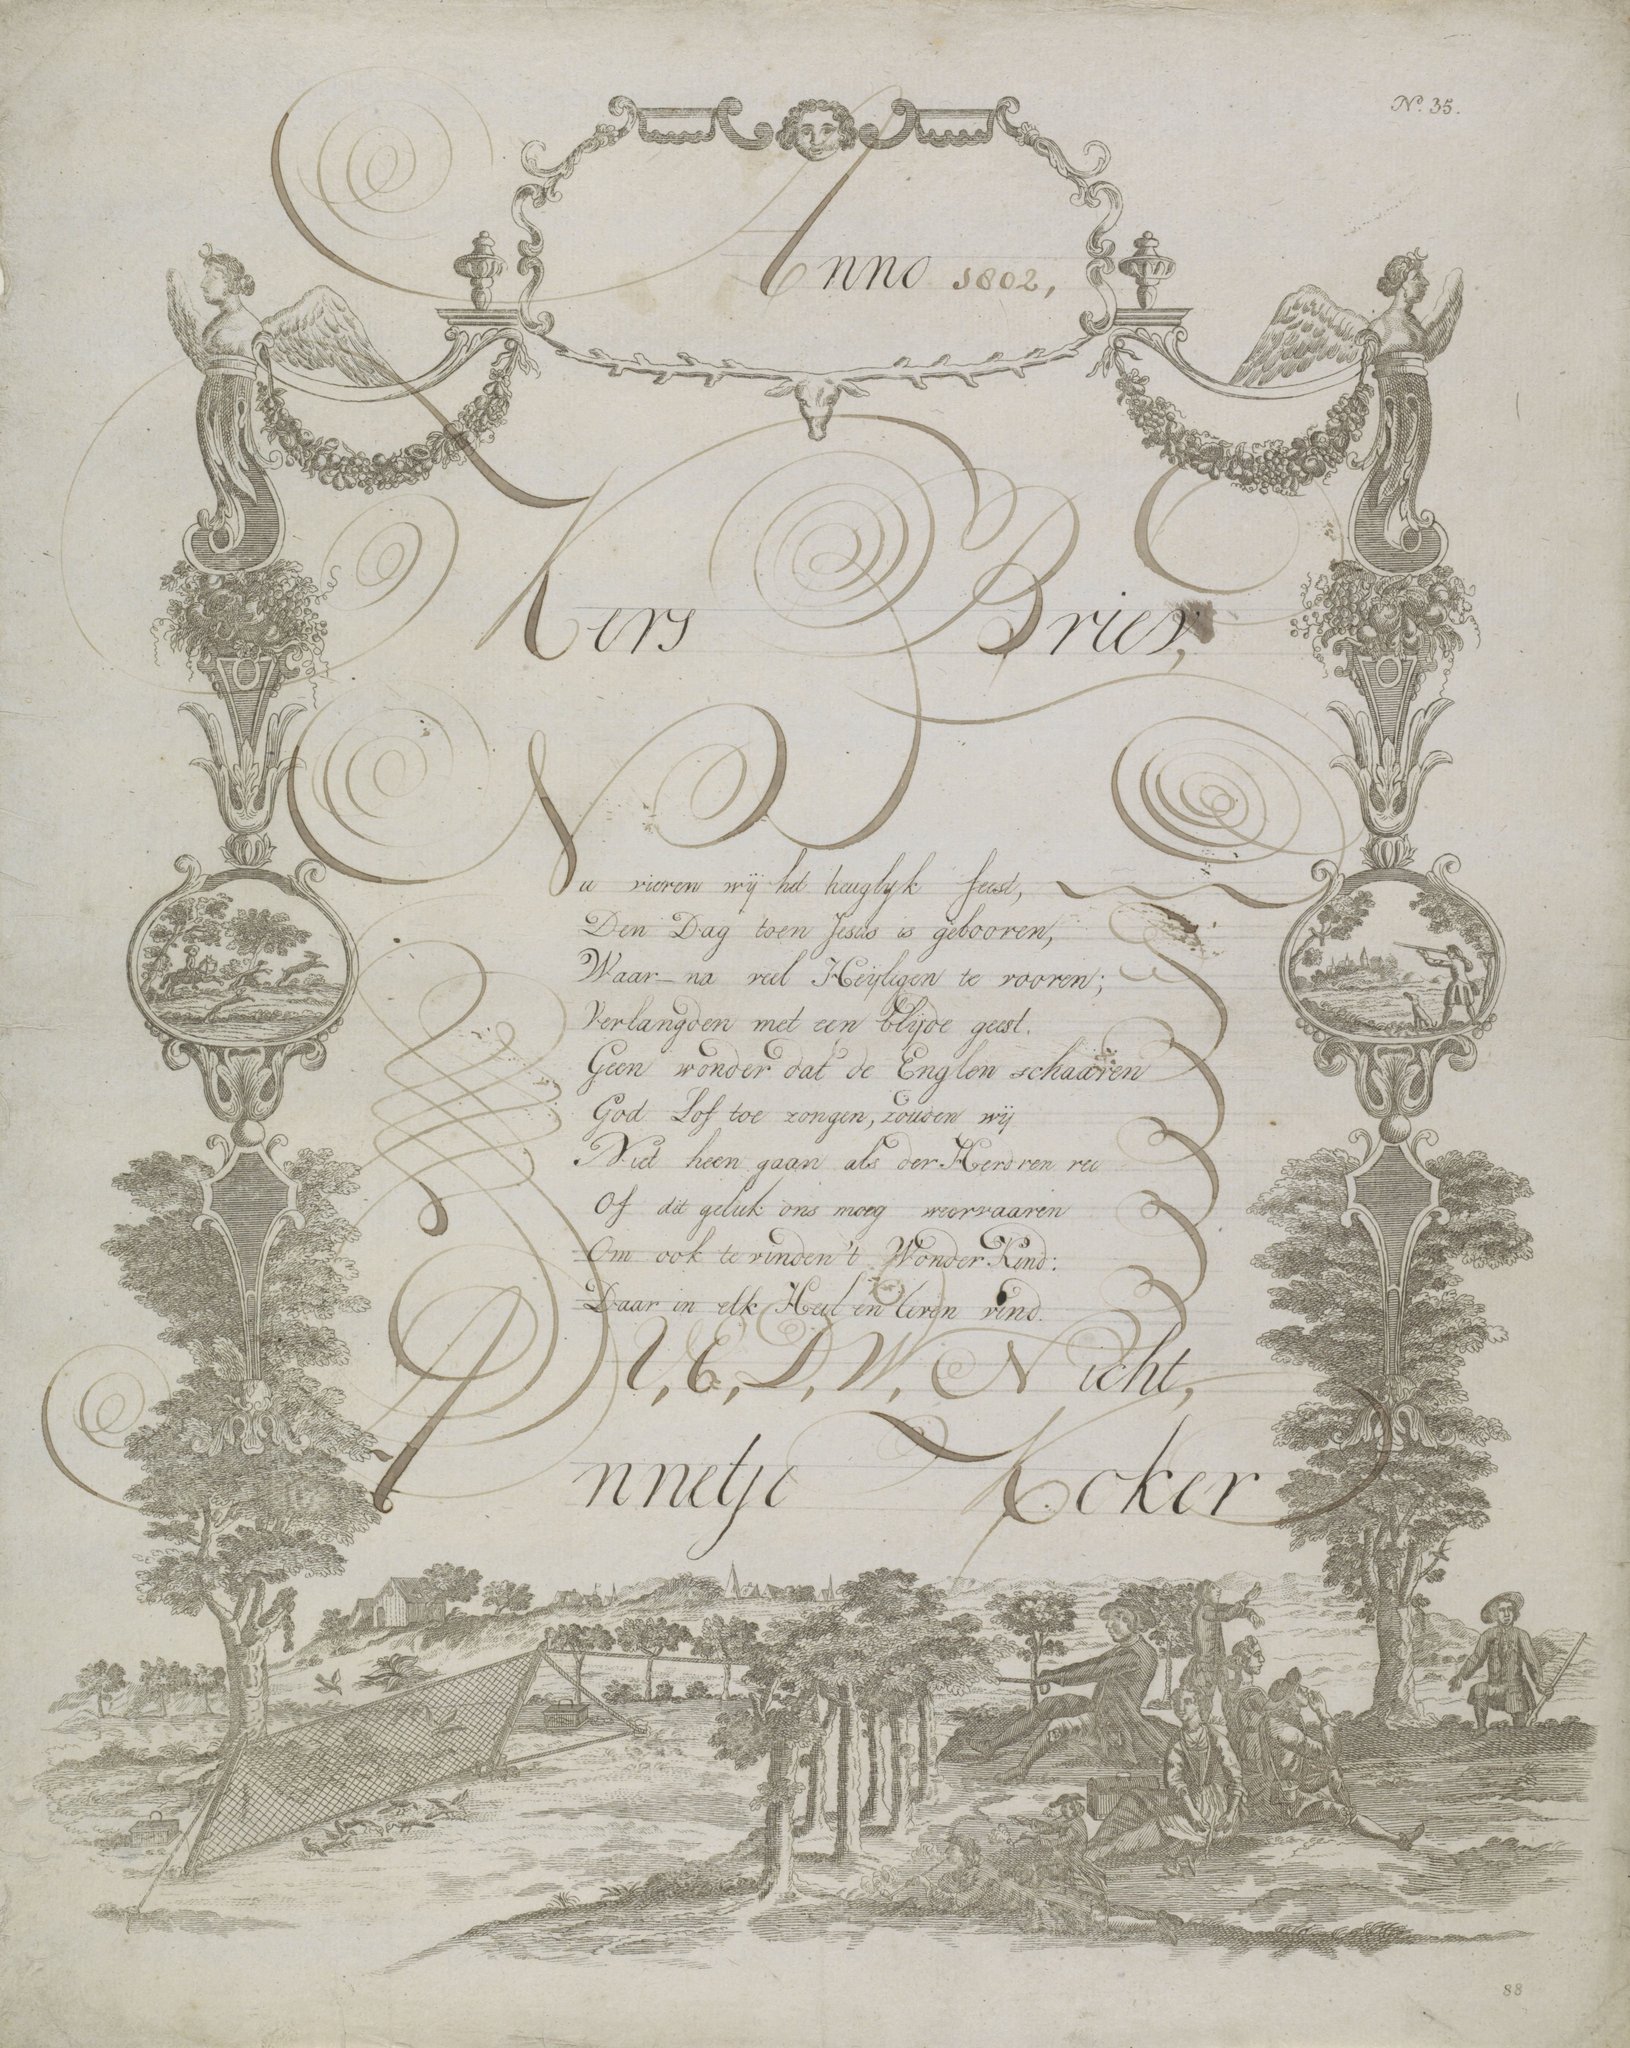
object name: popular print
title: Wensbrief met jachtscènes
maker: Anonymous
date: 1802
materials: ink, paper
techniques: calligraphy, etching, pen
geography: netherlands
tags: hunter, hunters hunting (n.b.: in 1988-1990 this notation denoted the concept of 43c11421 'hunters resting during the hunt'), hunters resting during the hunt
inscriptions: inscription: ‘Kers briev, / Nu vieren wij het heuglijk feest, / Den dag toen Jesus is gebooren ...’, collector's mark: Lugt 2760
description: Wensbrief met beschreven cartouche binnen een decoratief kader met jachtscènes, waaronder een grote voorstellingen van een groep mannen die vogels probeert te vangen met een groot net. Handgeschreven bericht in kalligrafie (Kerstbrief) door Annetje Koker. Genummerd rechtsboven: No. 35. Genummerd rechtsonder: 88.